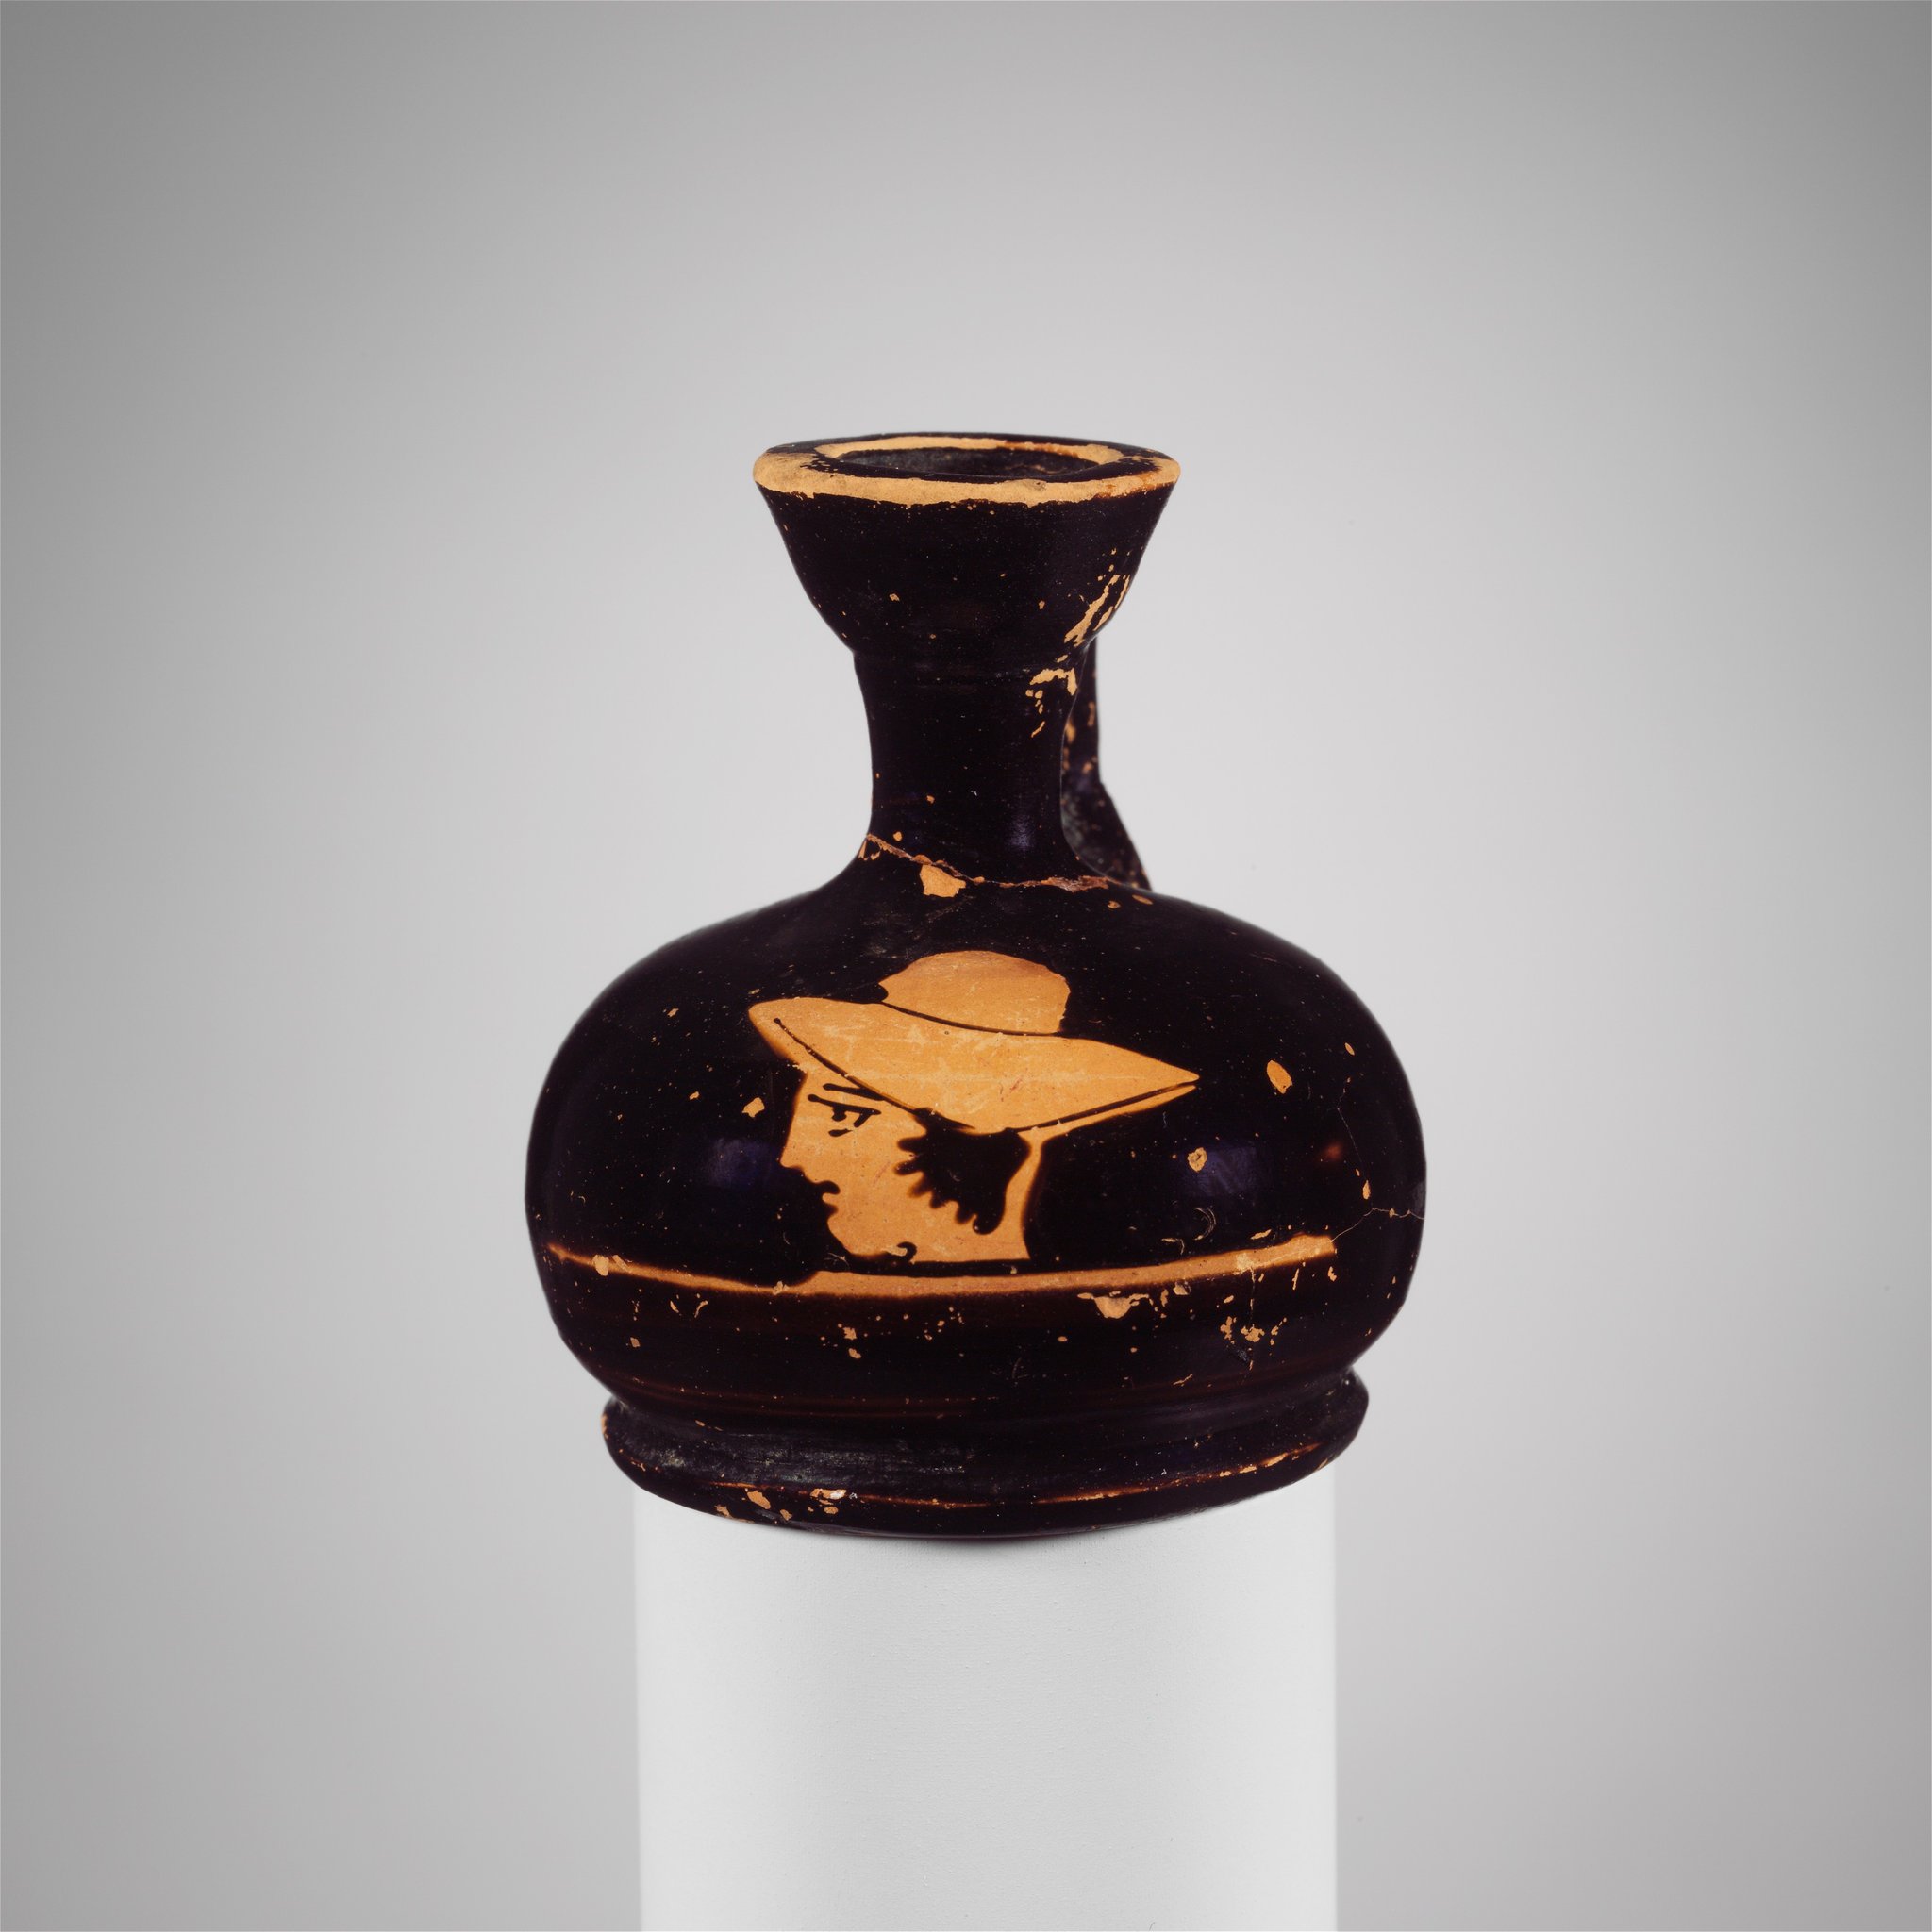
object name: squat lekythos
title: Terracotta squat lekythos (oil flask)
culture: greek, attic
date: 450-401 BCE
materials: terracotta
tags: hats,men,profiles